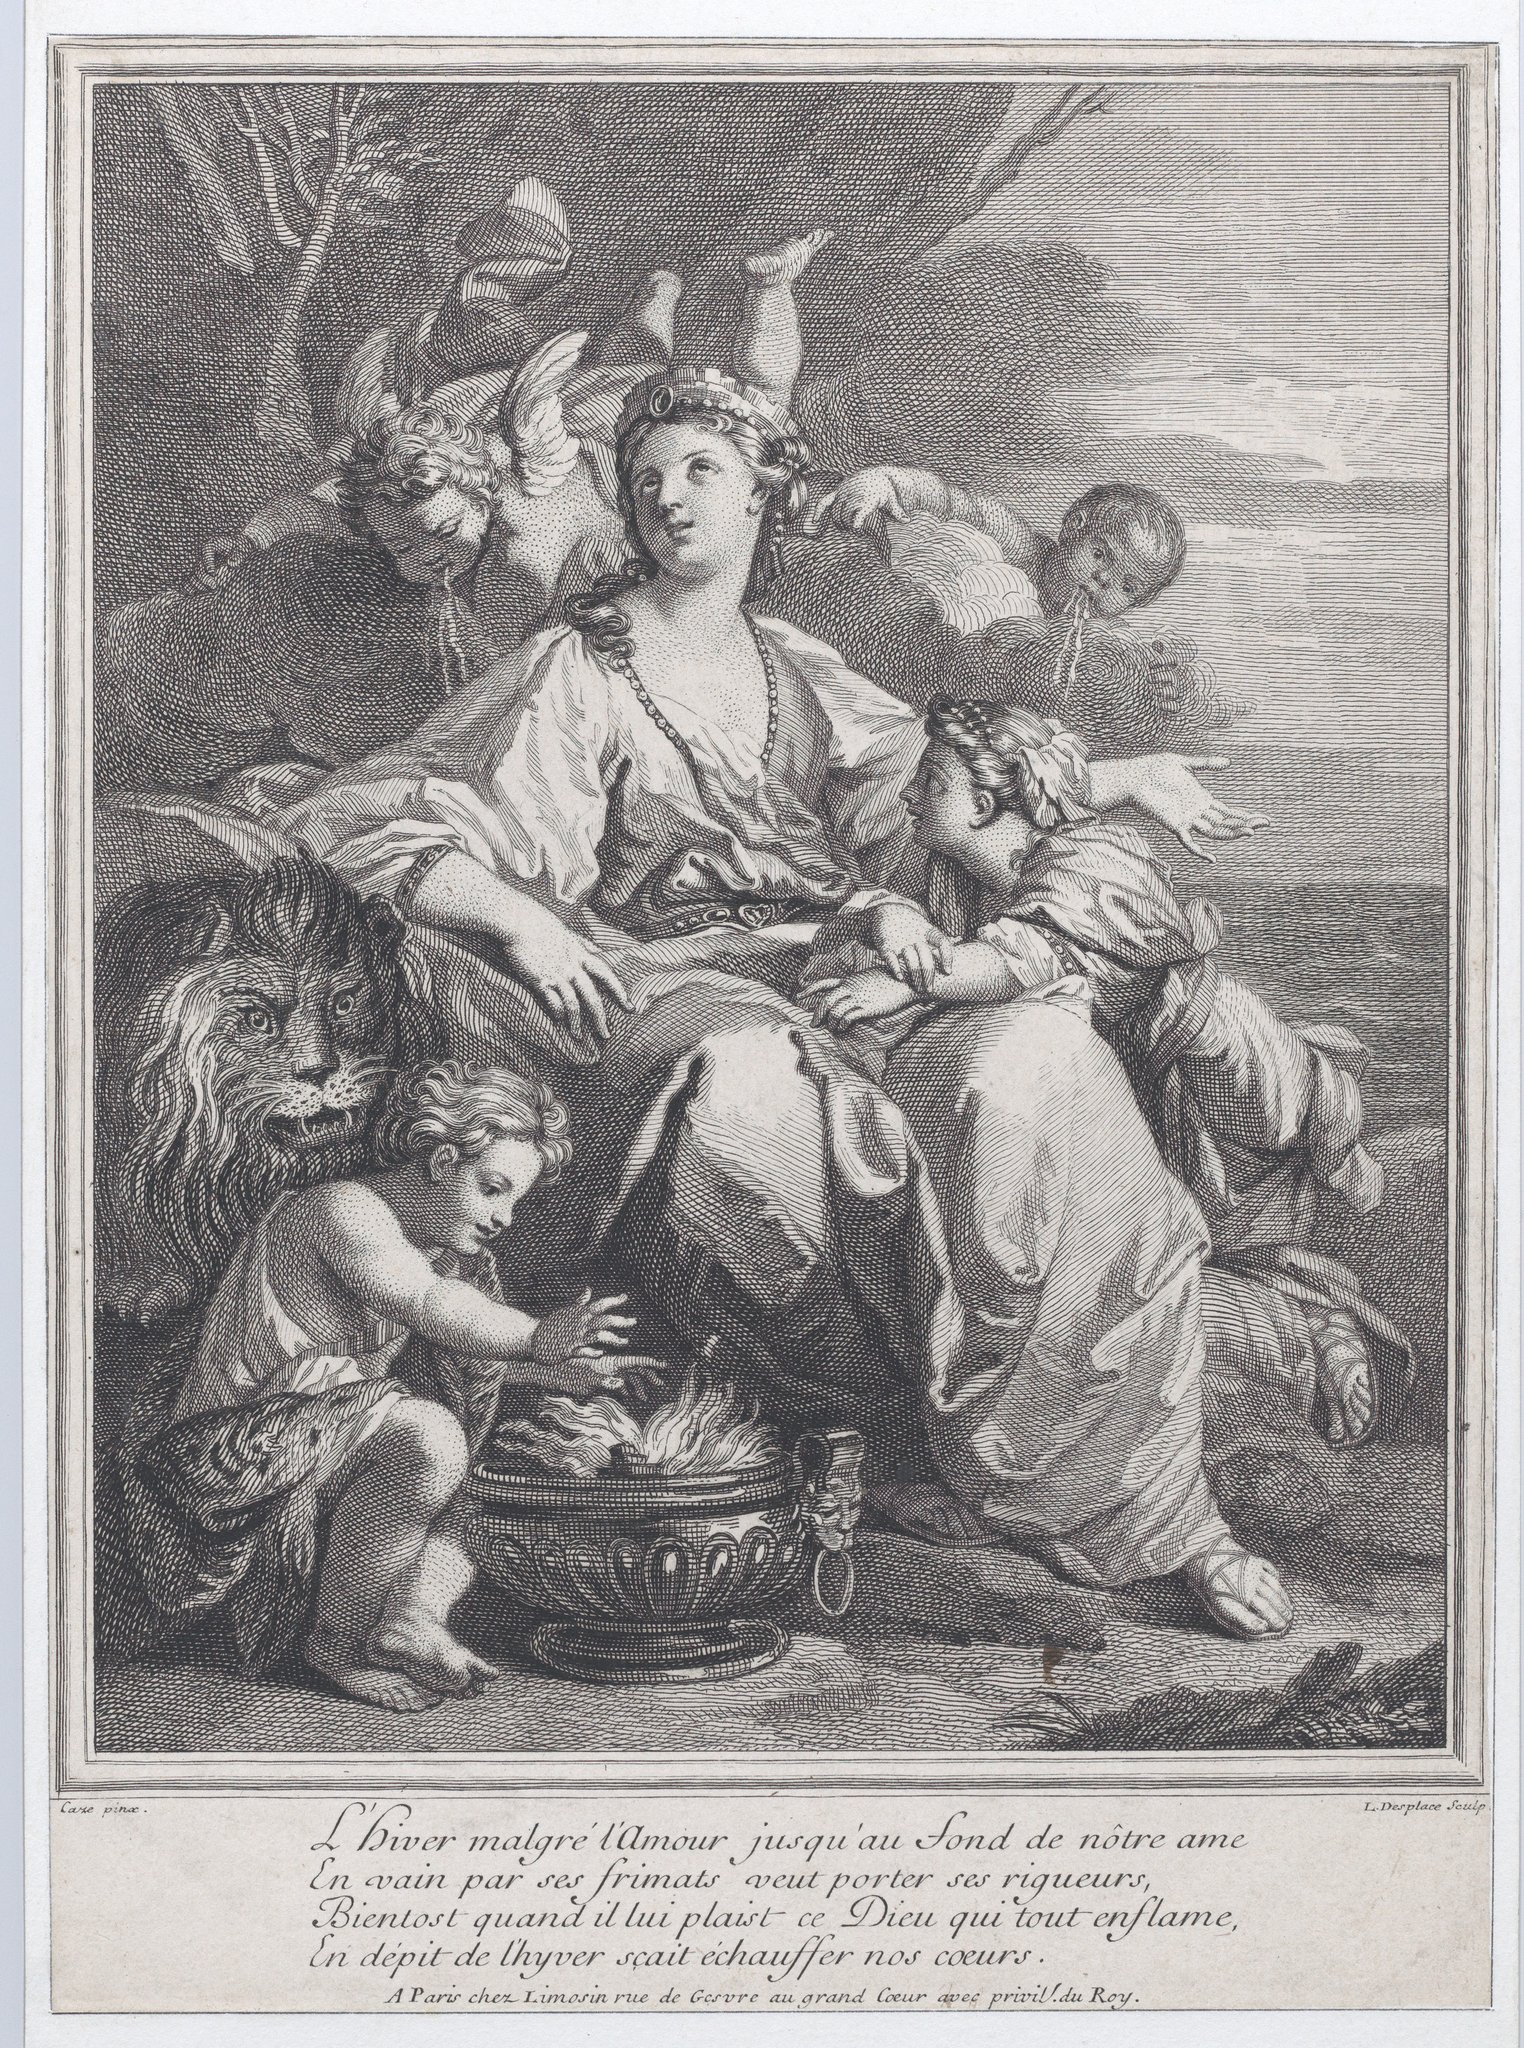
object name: print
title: Winter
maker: louis desplaces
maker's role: artist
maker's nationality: french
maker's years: 1682-1739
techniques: engraving, etching